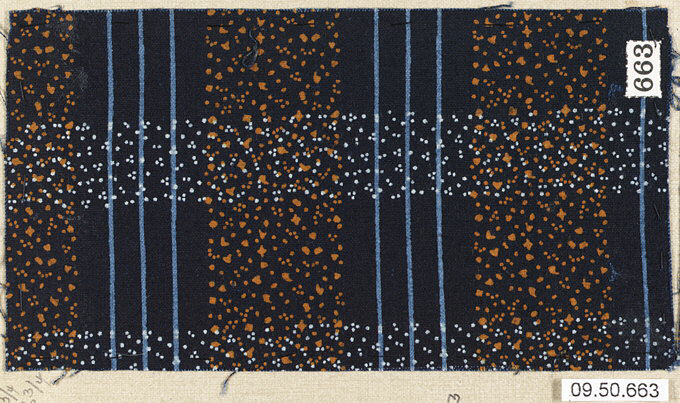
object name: piece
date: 1801-1900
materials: cotton